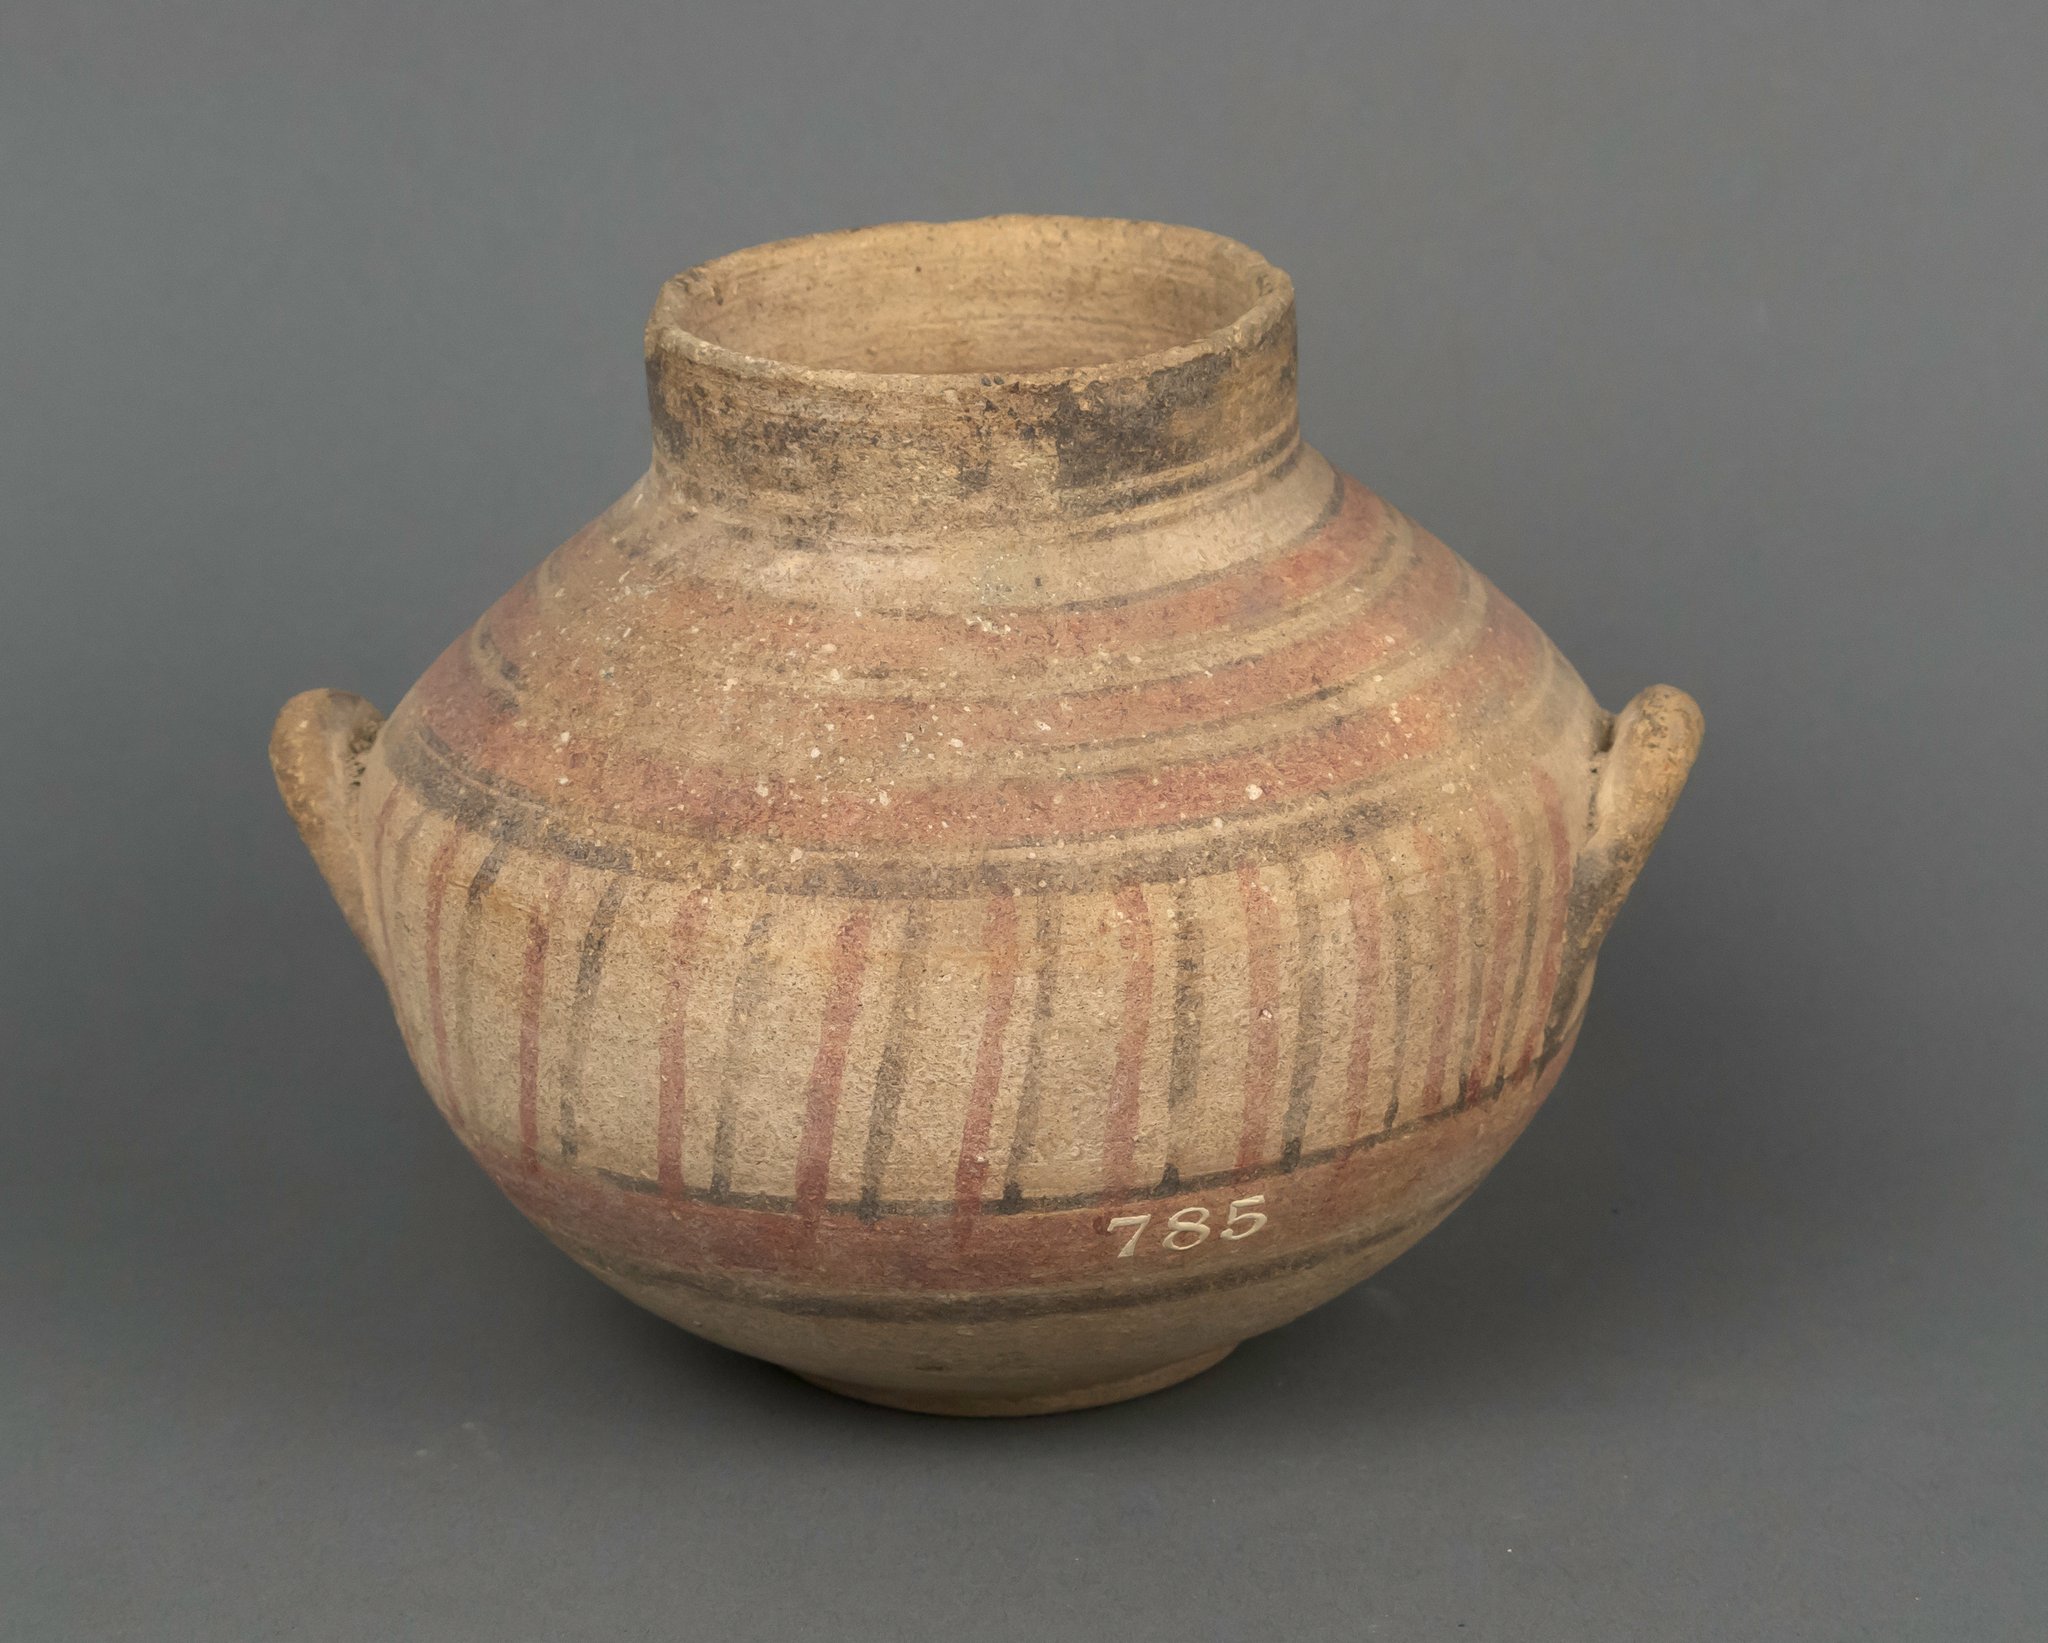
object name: dinos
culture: cypriot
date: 600-480 BCE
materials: terracotta